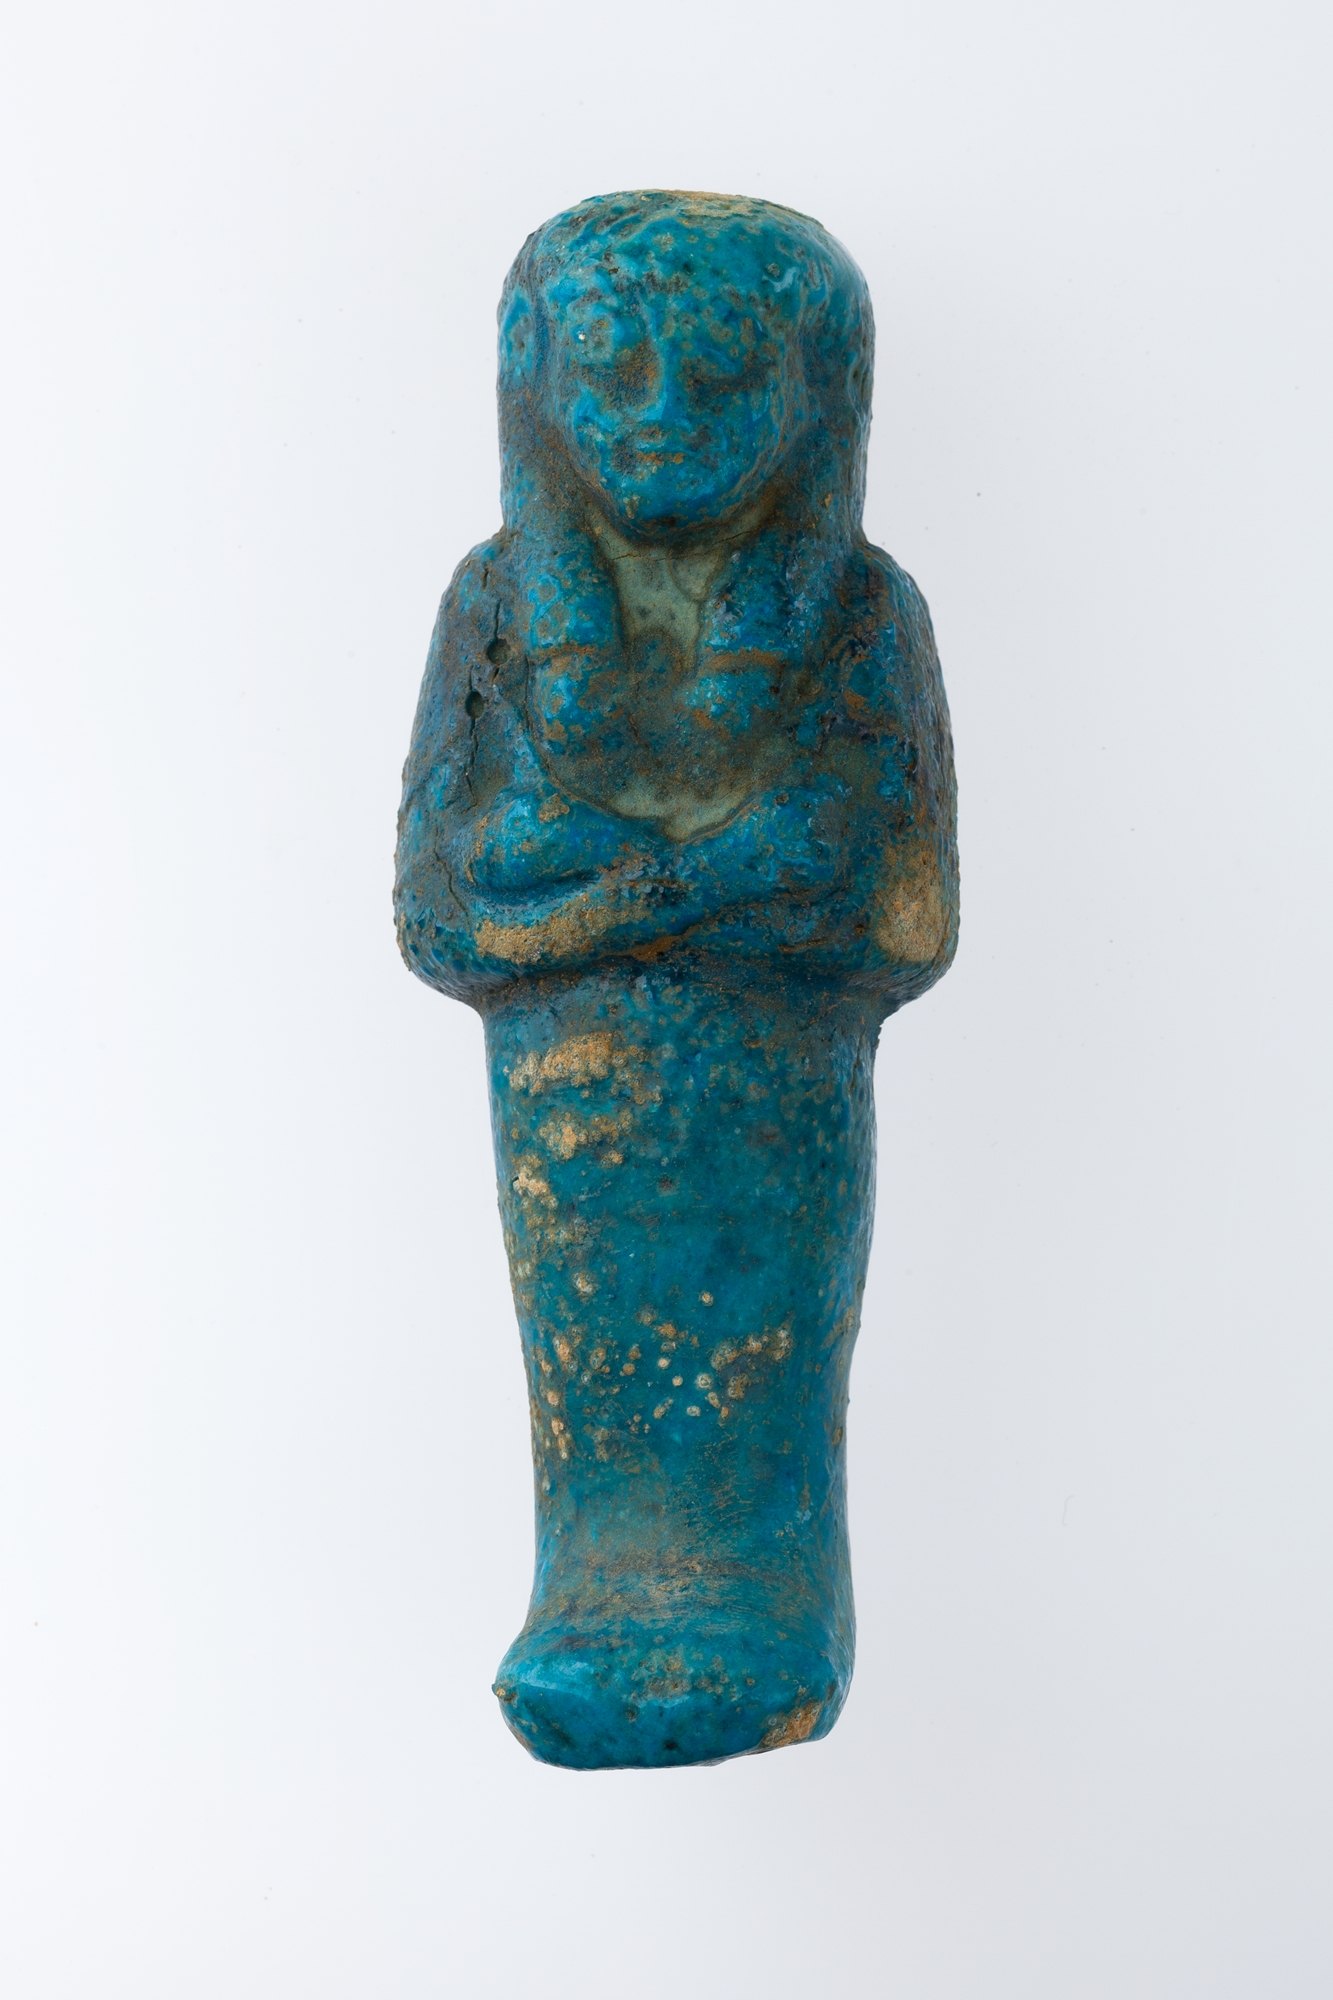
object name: shabti, henettawy c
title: Worker Shabti of Henettawy (C), Daughter of Isetemkheb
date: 990-970 BCE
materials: faience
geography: egypt